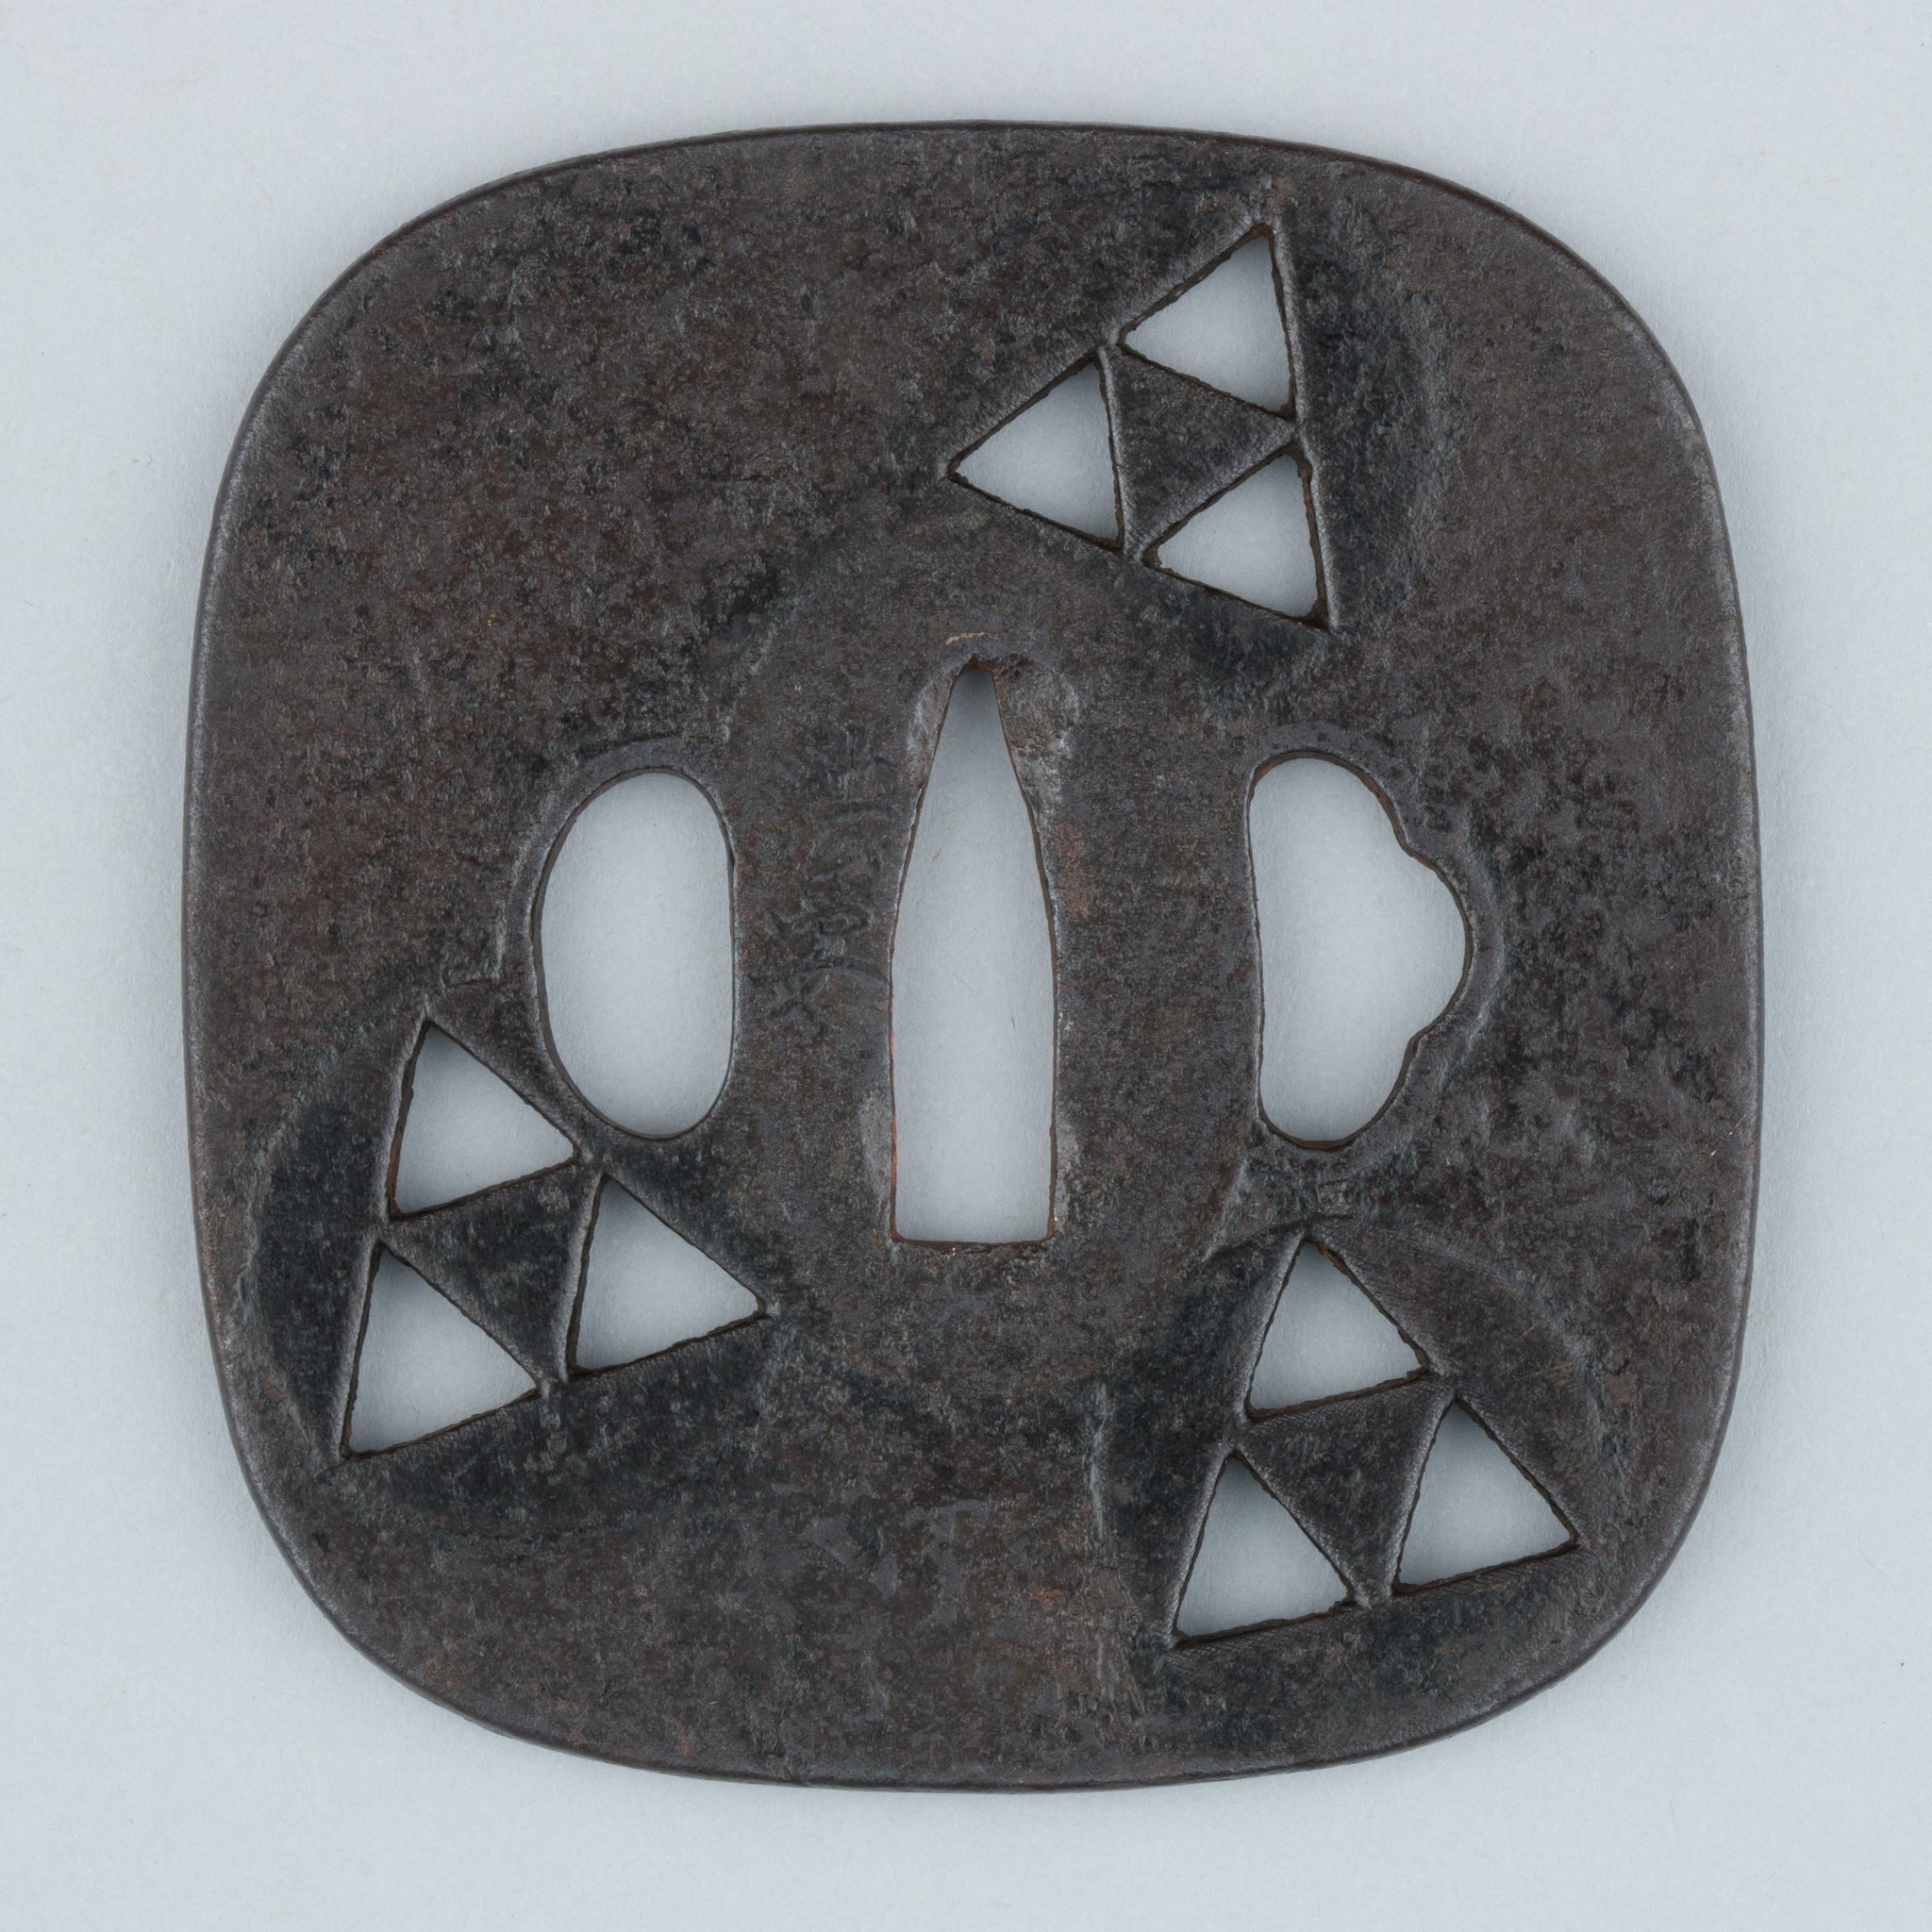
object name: sword guard tsuba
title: Sword Guard (Tsuba)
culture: japanese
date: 1601-1625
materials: copper, gold, iron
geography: japan